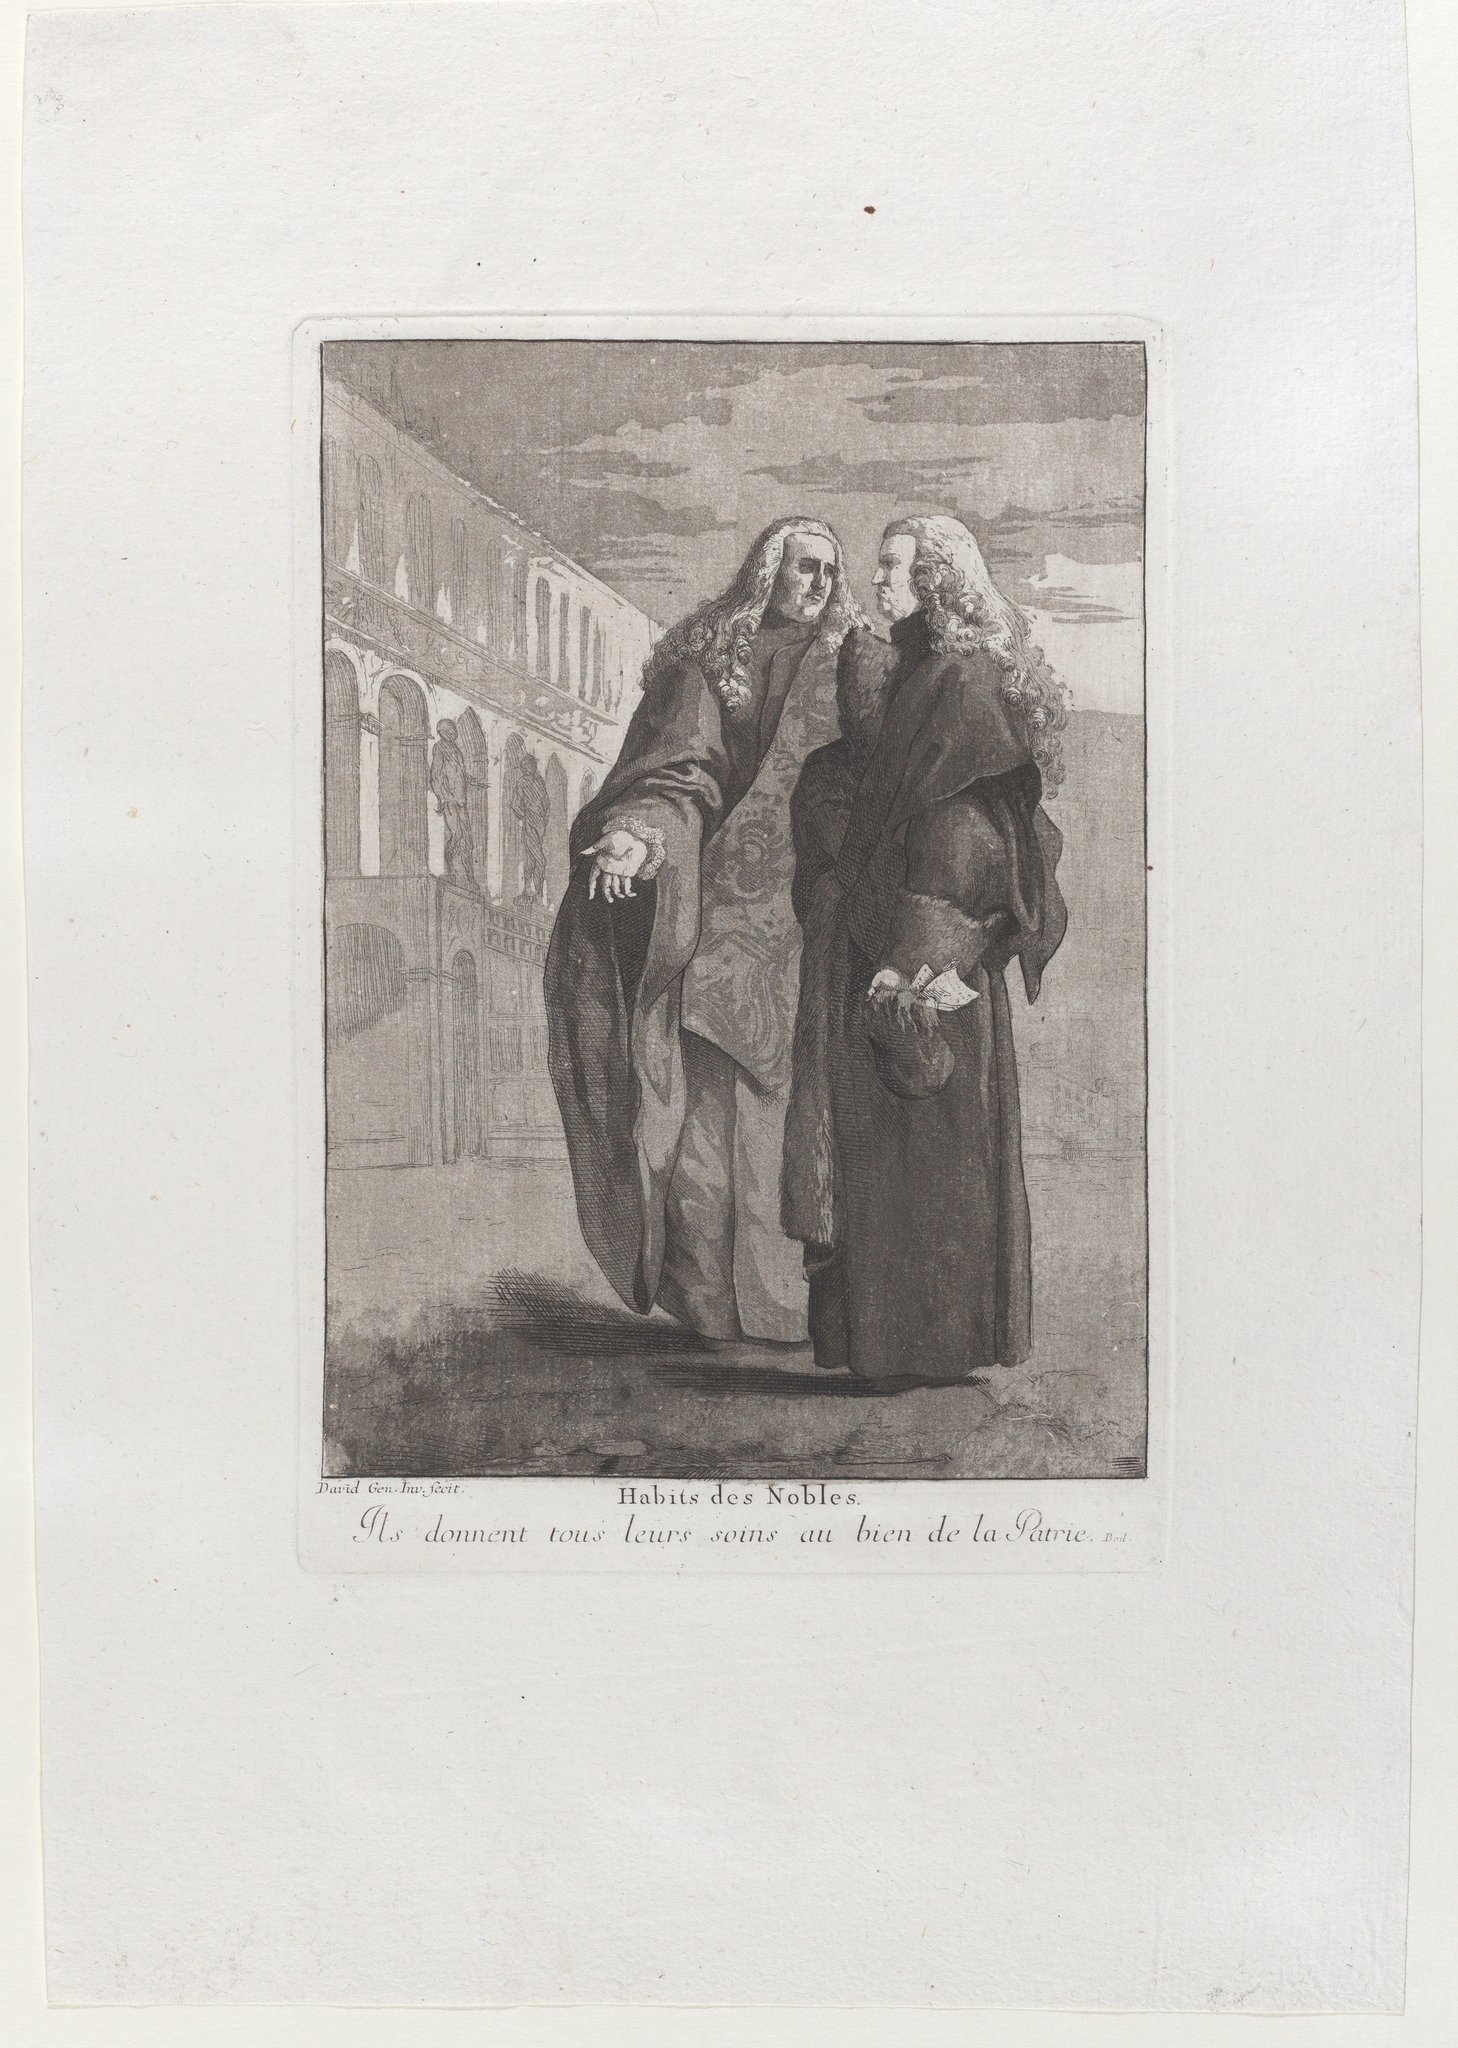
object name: print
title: Two Venetian magistrates standing in front of the Palazzo Ducale, from the 'Divers portraits gravés à l'eau-forte et dediés à M.Dominique Corvi'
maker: giovanni david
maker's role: artist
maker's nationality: italian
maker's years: 1749-1790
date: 1775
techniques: aquatint, etching